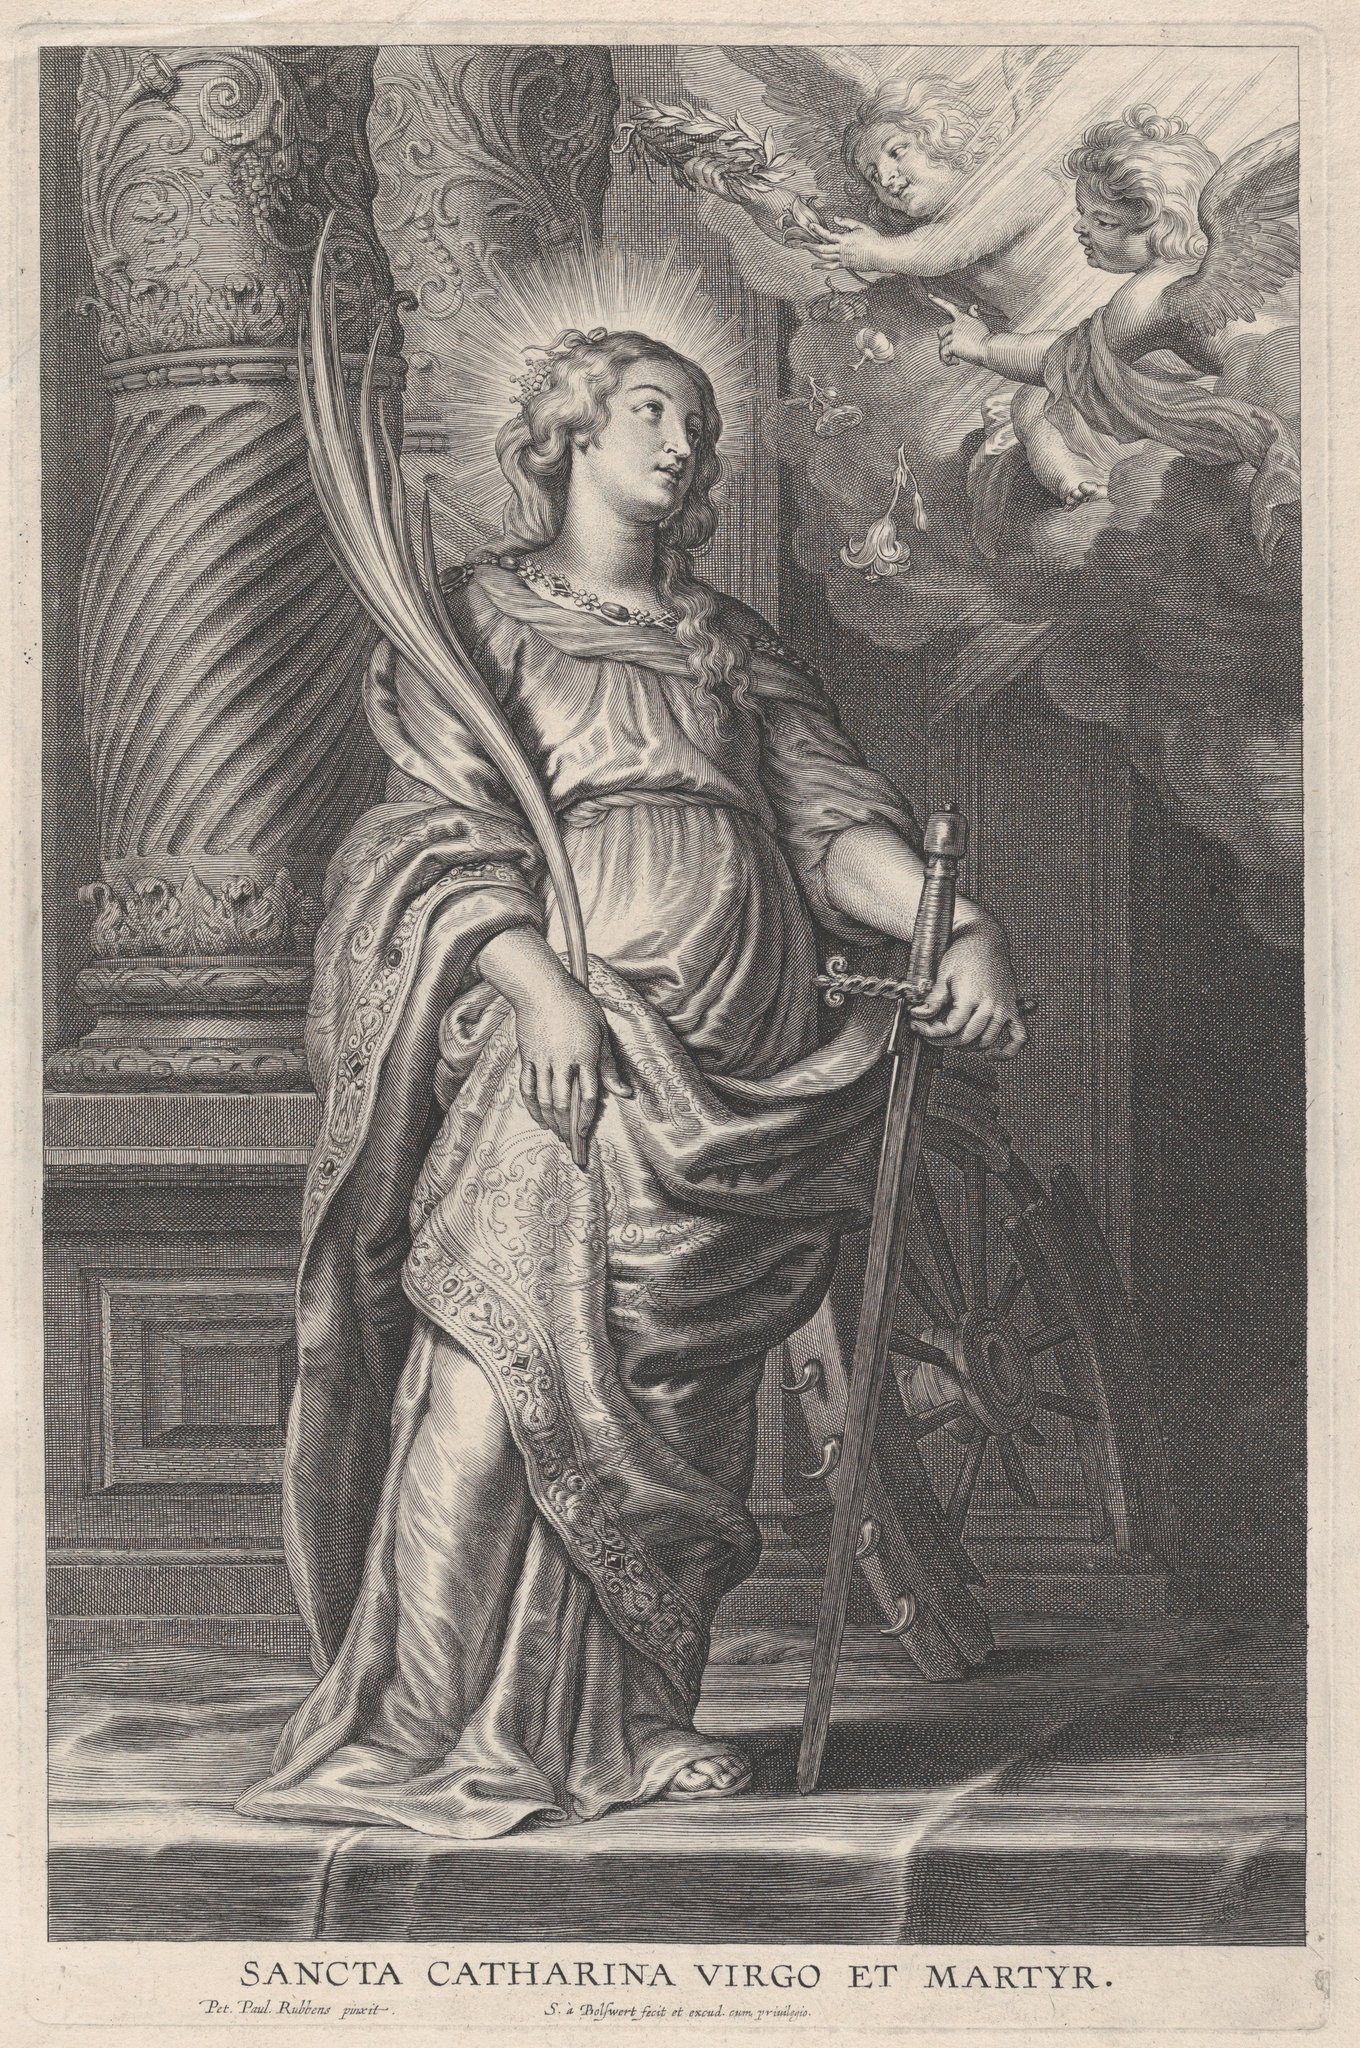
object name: print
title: Saint Catherine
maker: schelte adams à bolswert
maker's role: artist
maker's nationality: dutch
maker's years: 1581-1659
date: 1600-1659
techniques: engraving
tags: swords,angels,saint catherine